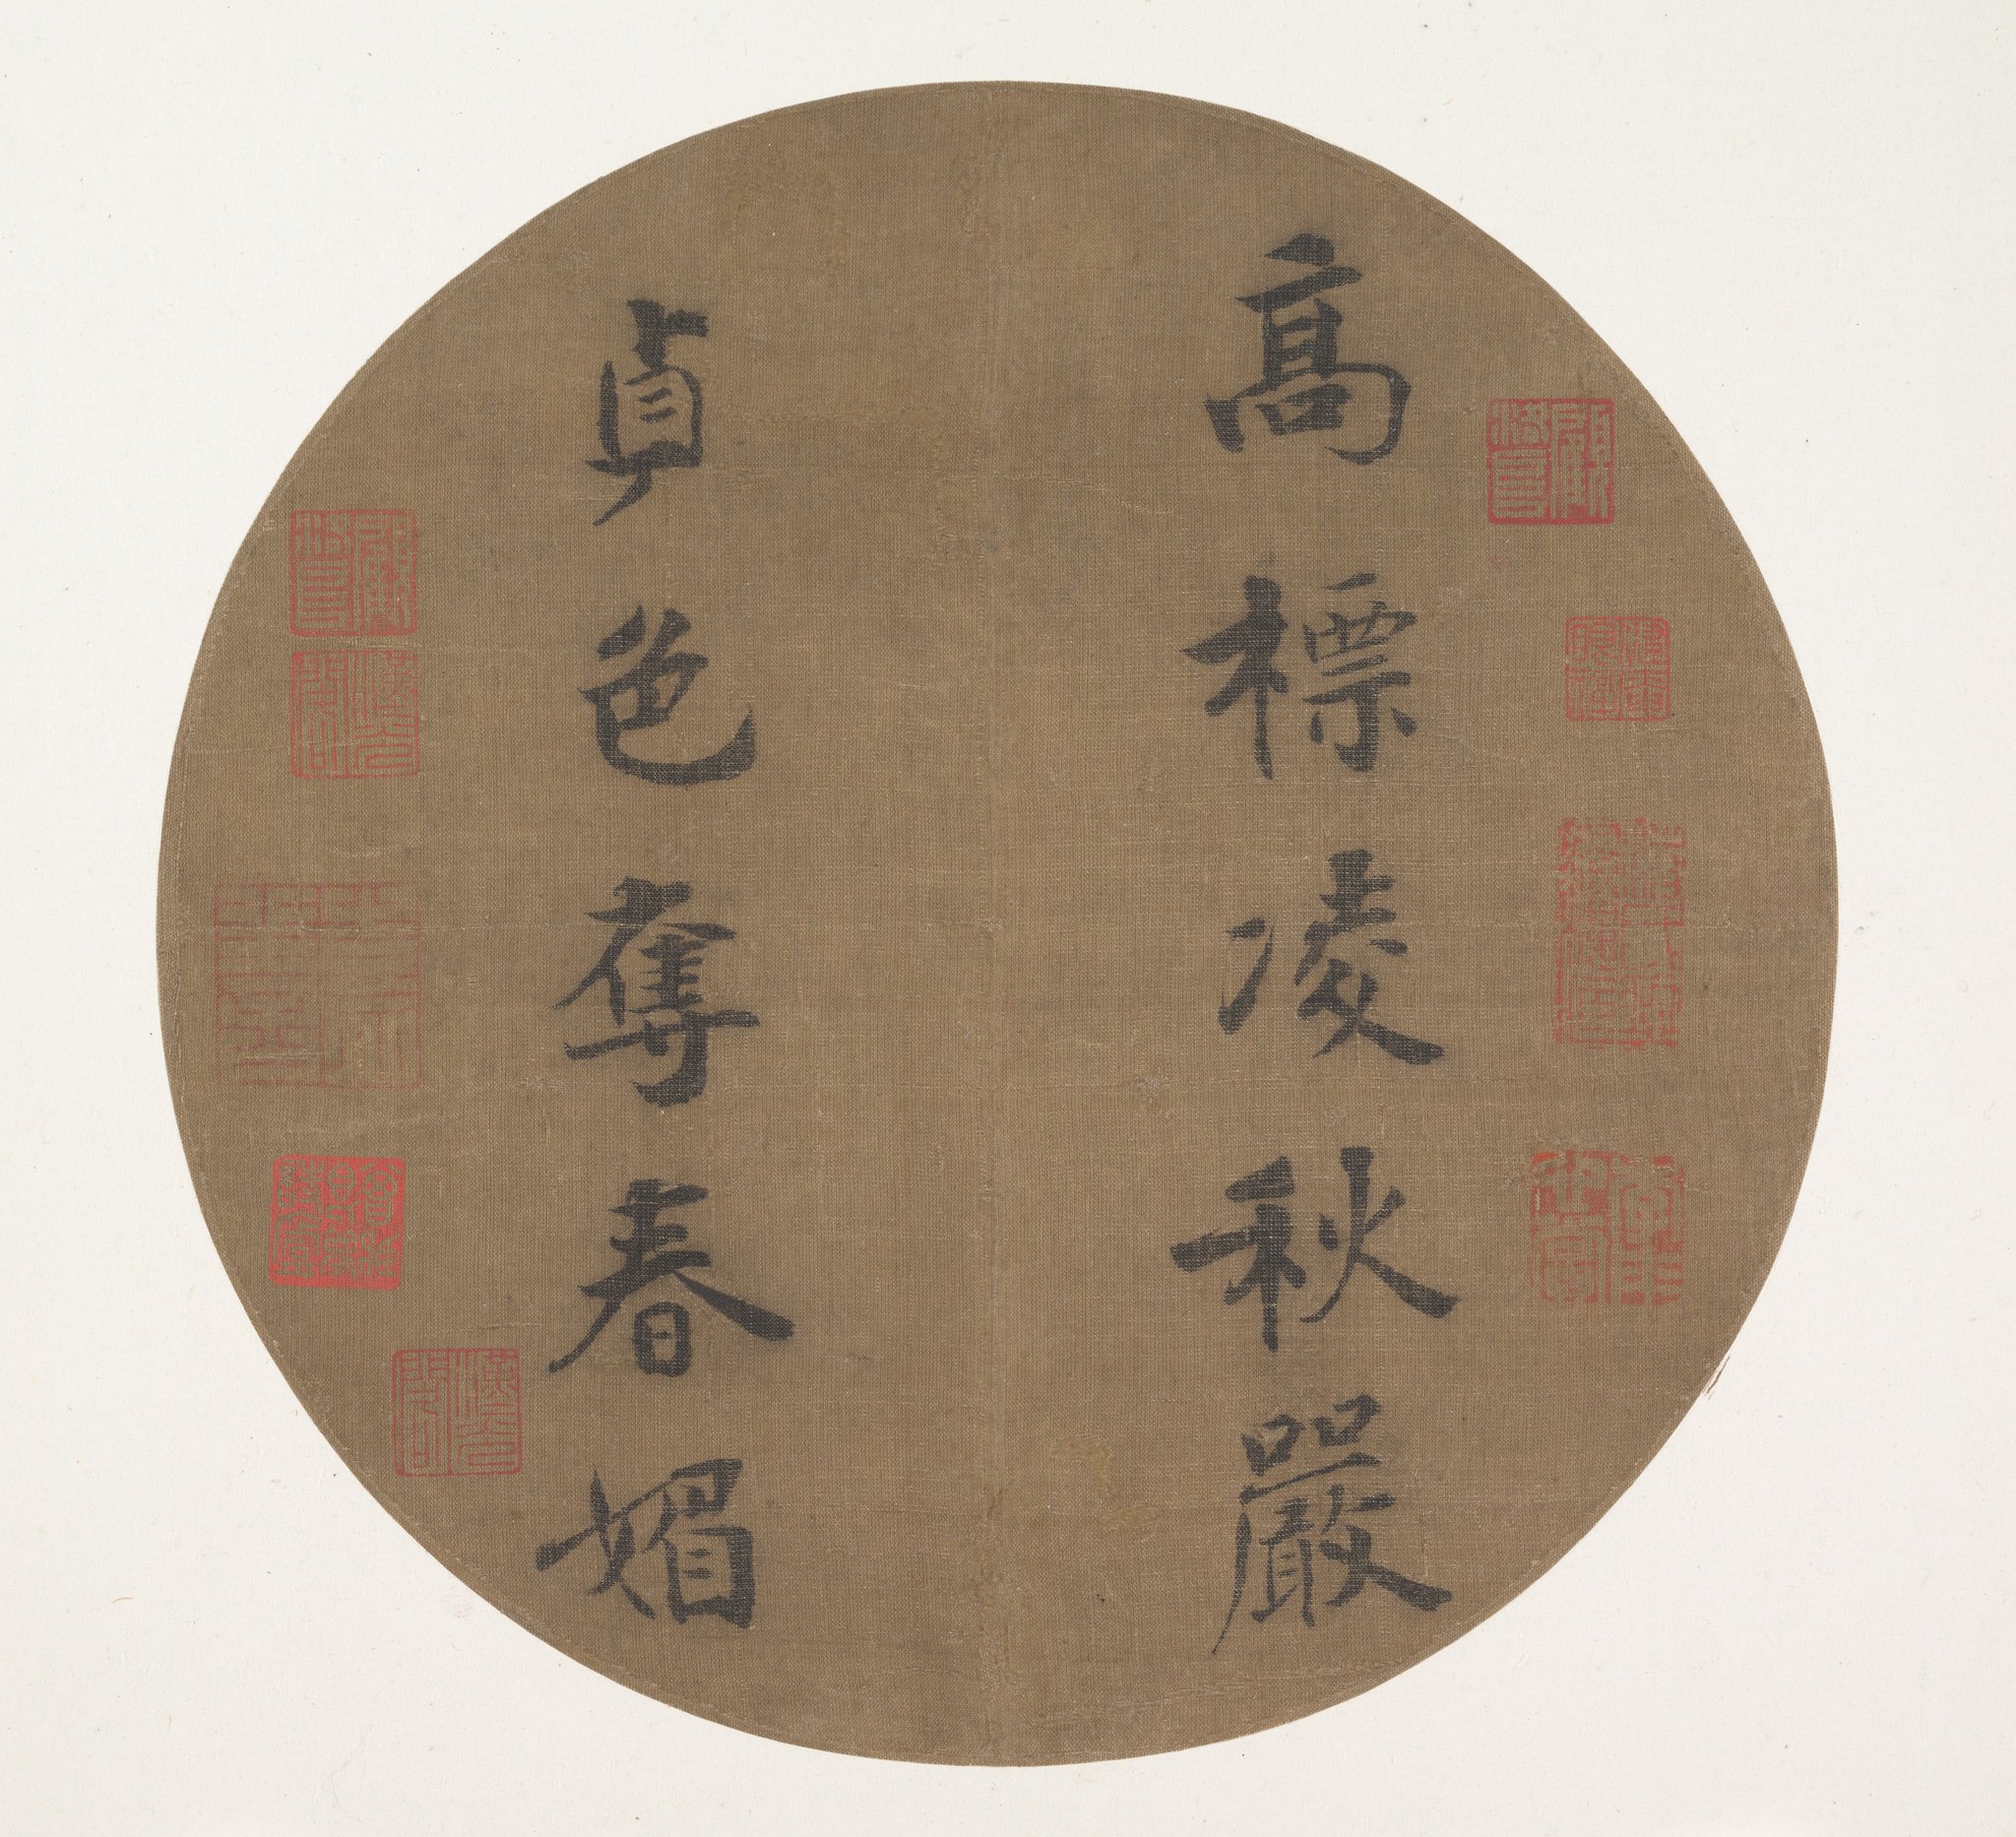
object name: fan mounted a an album leaf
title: Couplet by Han Yu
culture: chinese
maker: emperor guangzong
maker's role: artist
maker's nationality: chinese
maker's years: 1147-1200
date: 1147-1200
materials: ink, silk